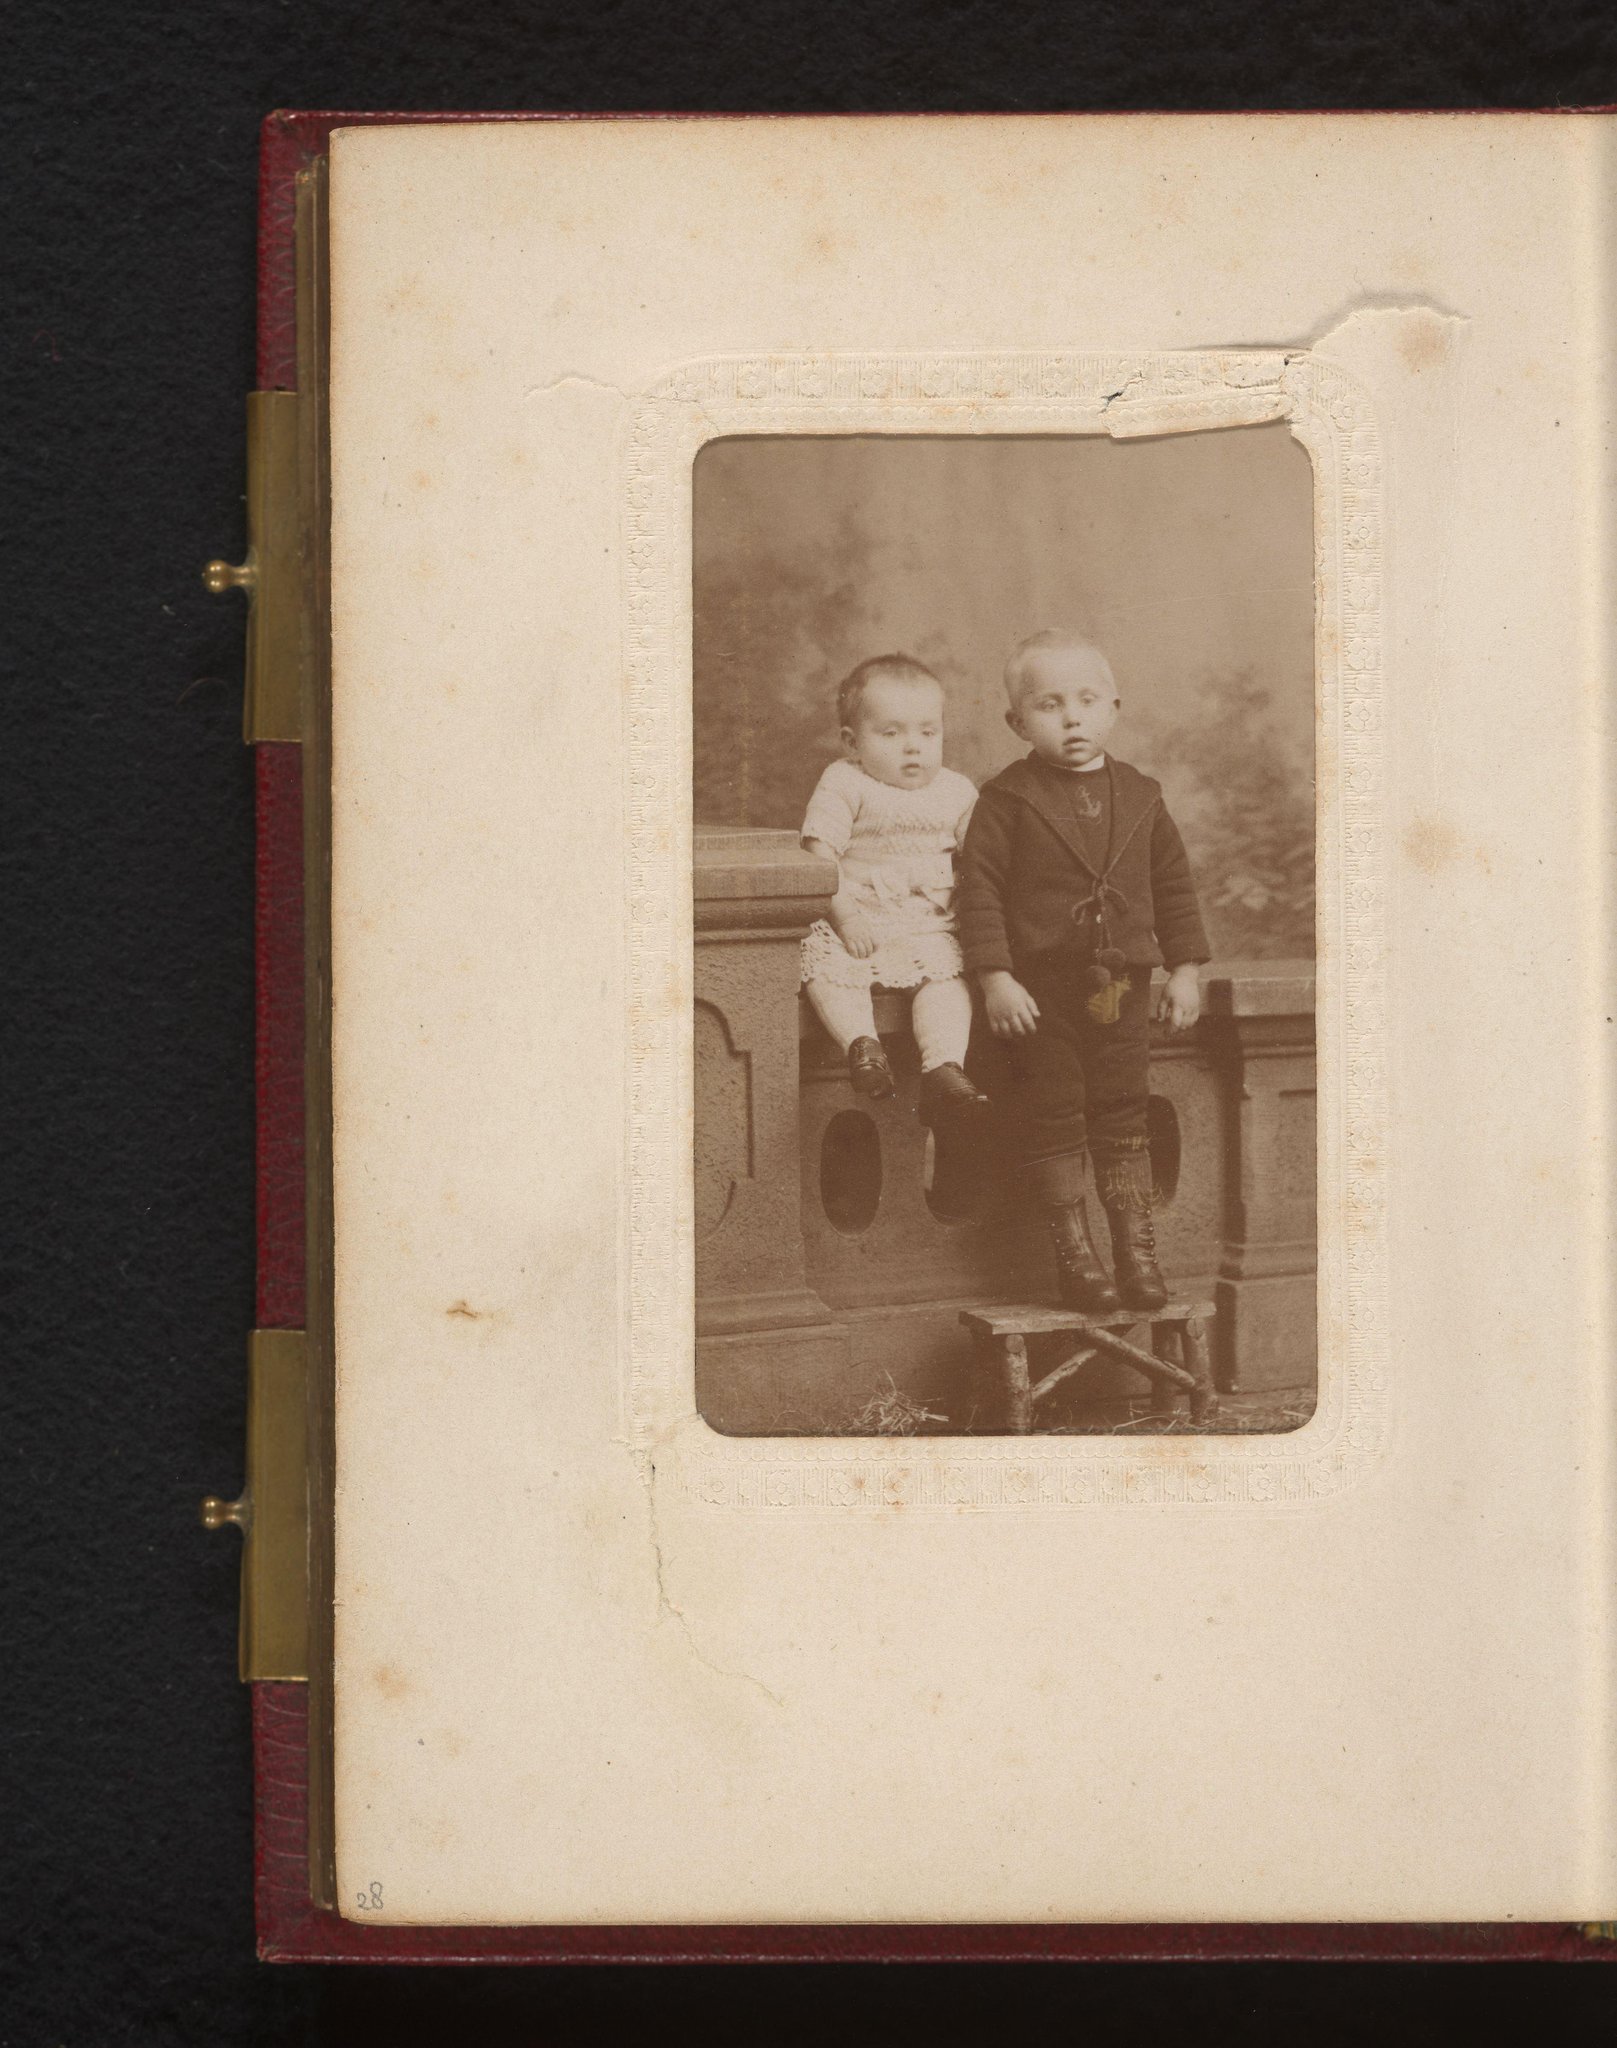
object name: carte de visite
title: Portret van een baby en een jongen, zittend op en staand bij een balustrade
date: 1860-1890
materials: cardboard, photographic support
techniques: albumen print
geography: kampen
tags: historical persons, toddler (male), balustrade, infant, baby ~ the ages of man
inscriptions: inscription: ‘Atelier/ voor/ Photographie/ De Koe & Co./ Kampen.’